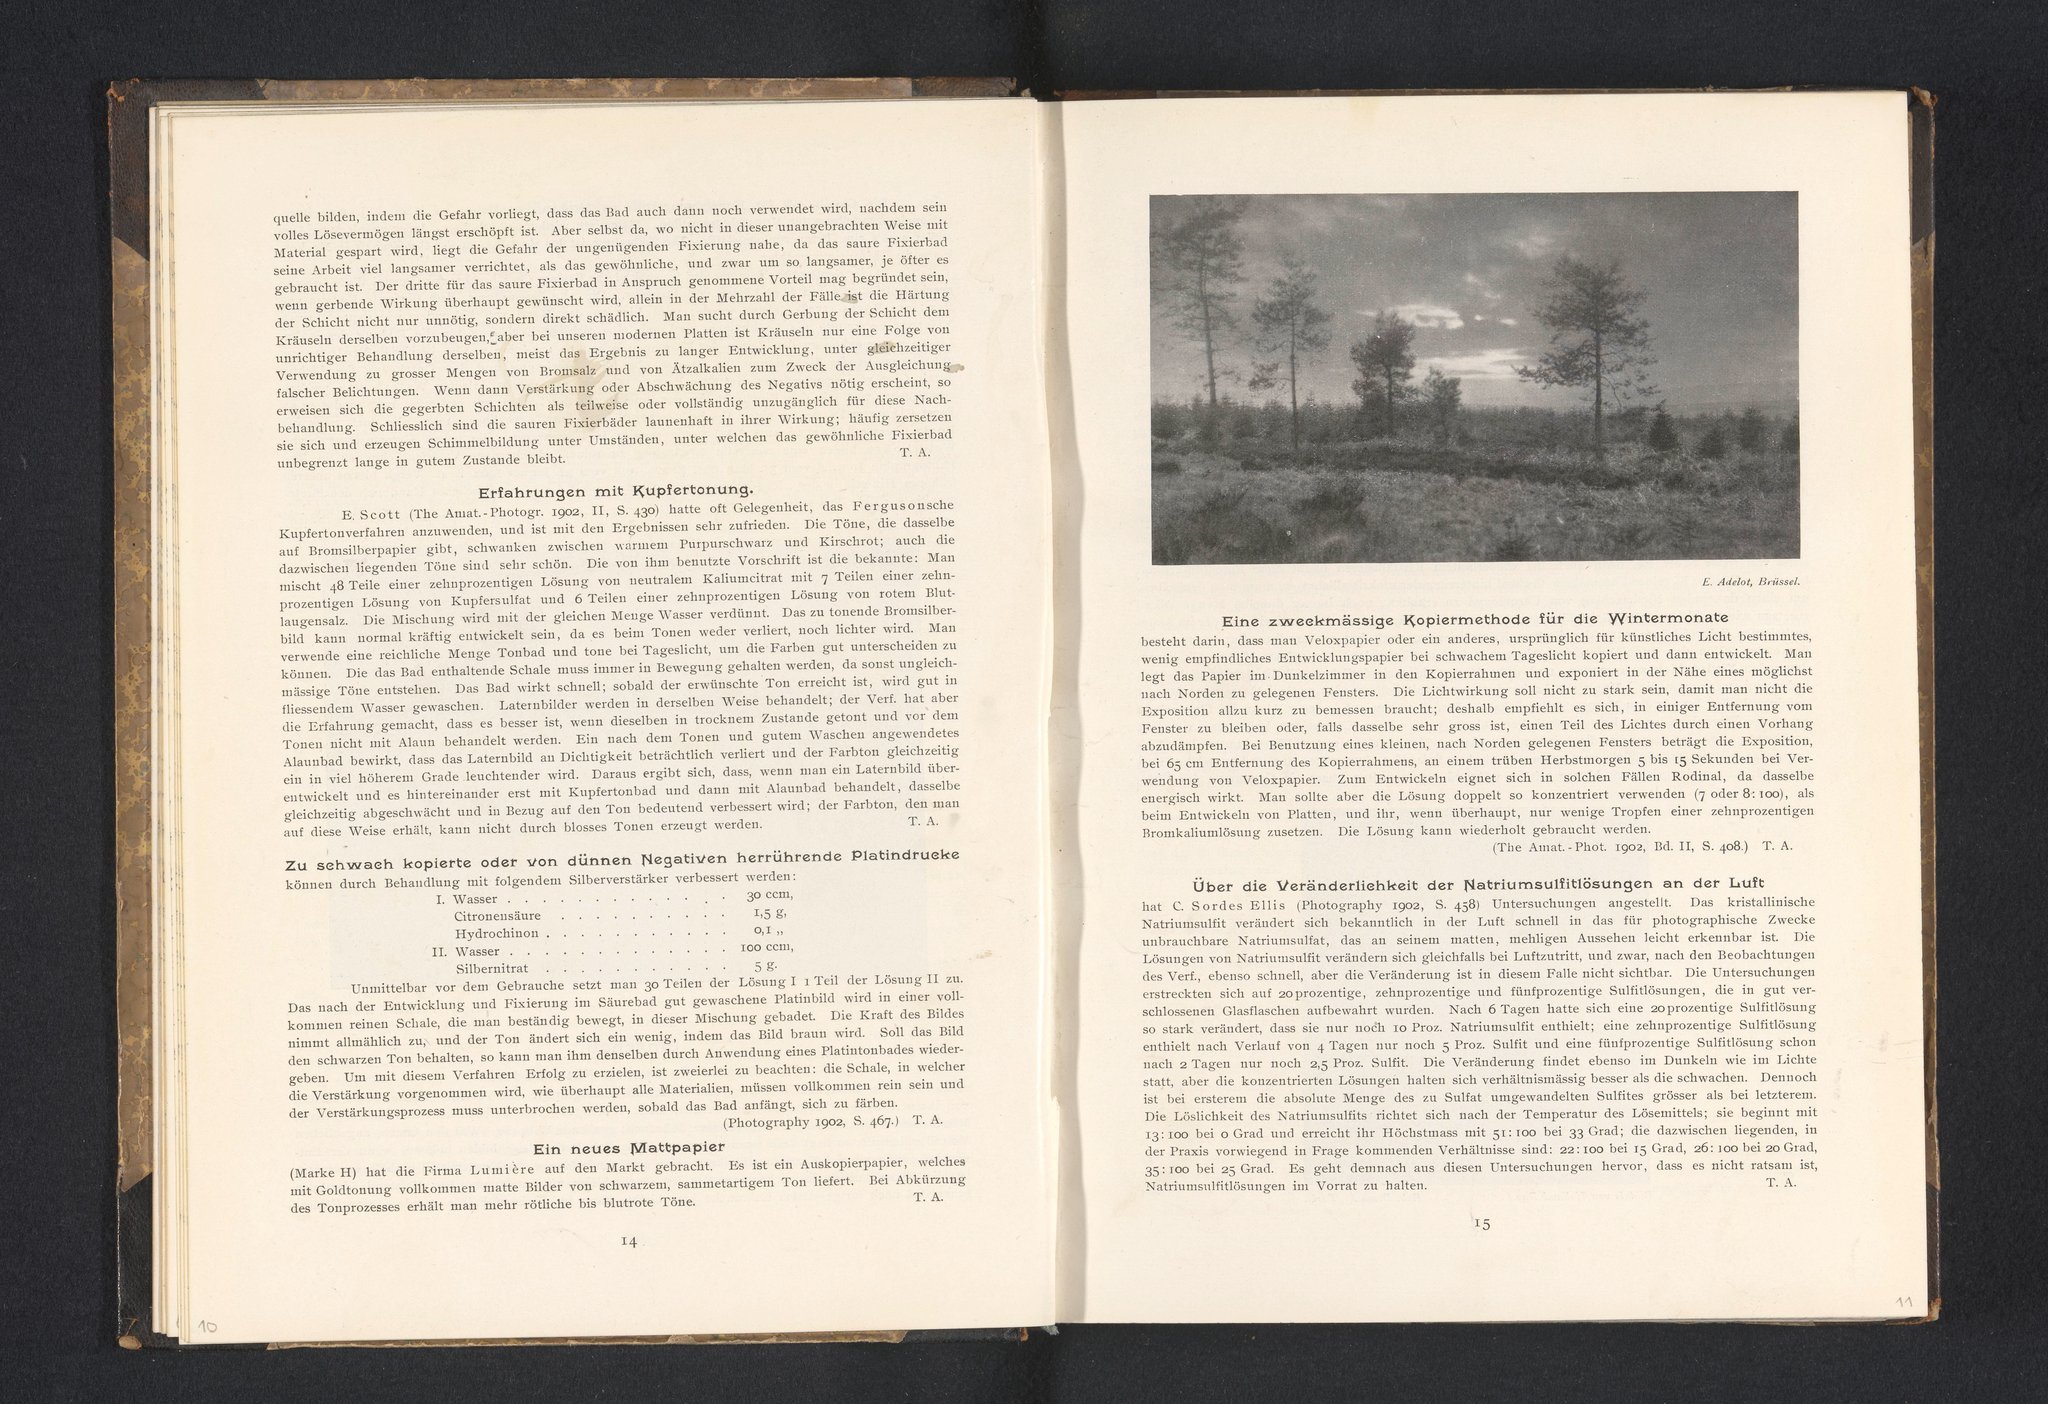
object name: page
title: Landschap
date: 1898-1903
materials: paper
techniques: autotype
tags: landscapes